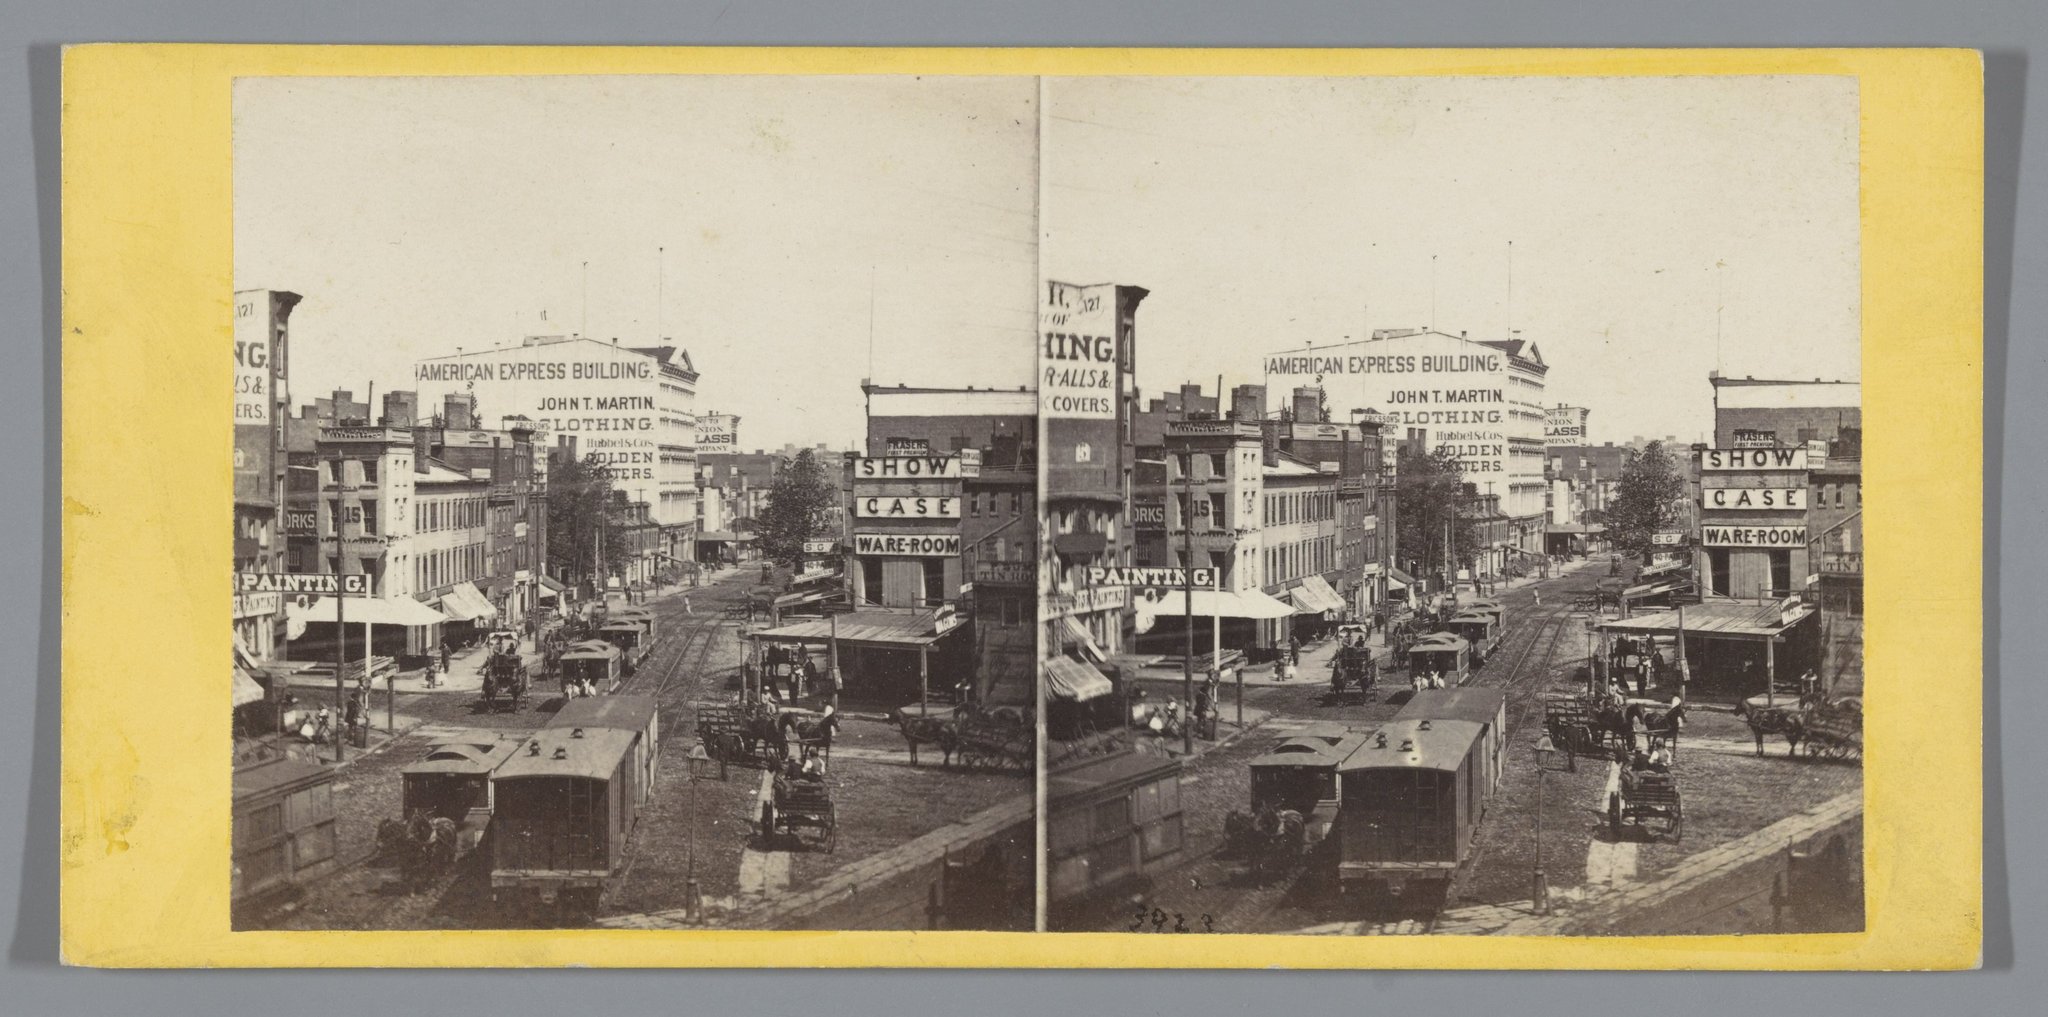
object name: stereograph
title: Hudson Street, gezien vanaf de kruising met Chambers Street, New York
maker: Anonymous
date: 1861-1871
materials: cardboard, paper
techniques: albumen print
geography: new york city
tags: street, new york (city)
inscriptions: number: ‘3923’, address: ‘American and Foreign Stereoscopic Emporium, 501 Broadway, New York.’